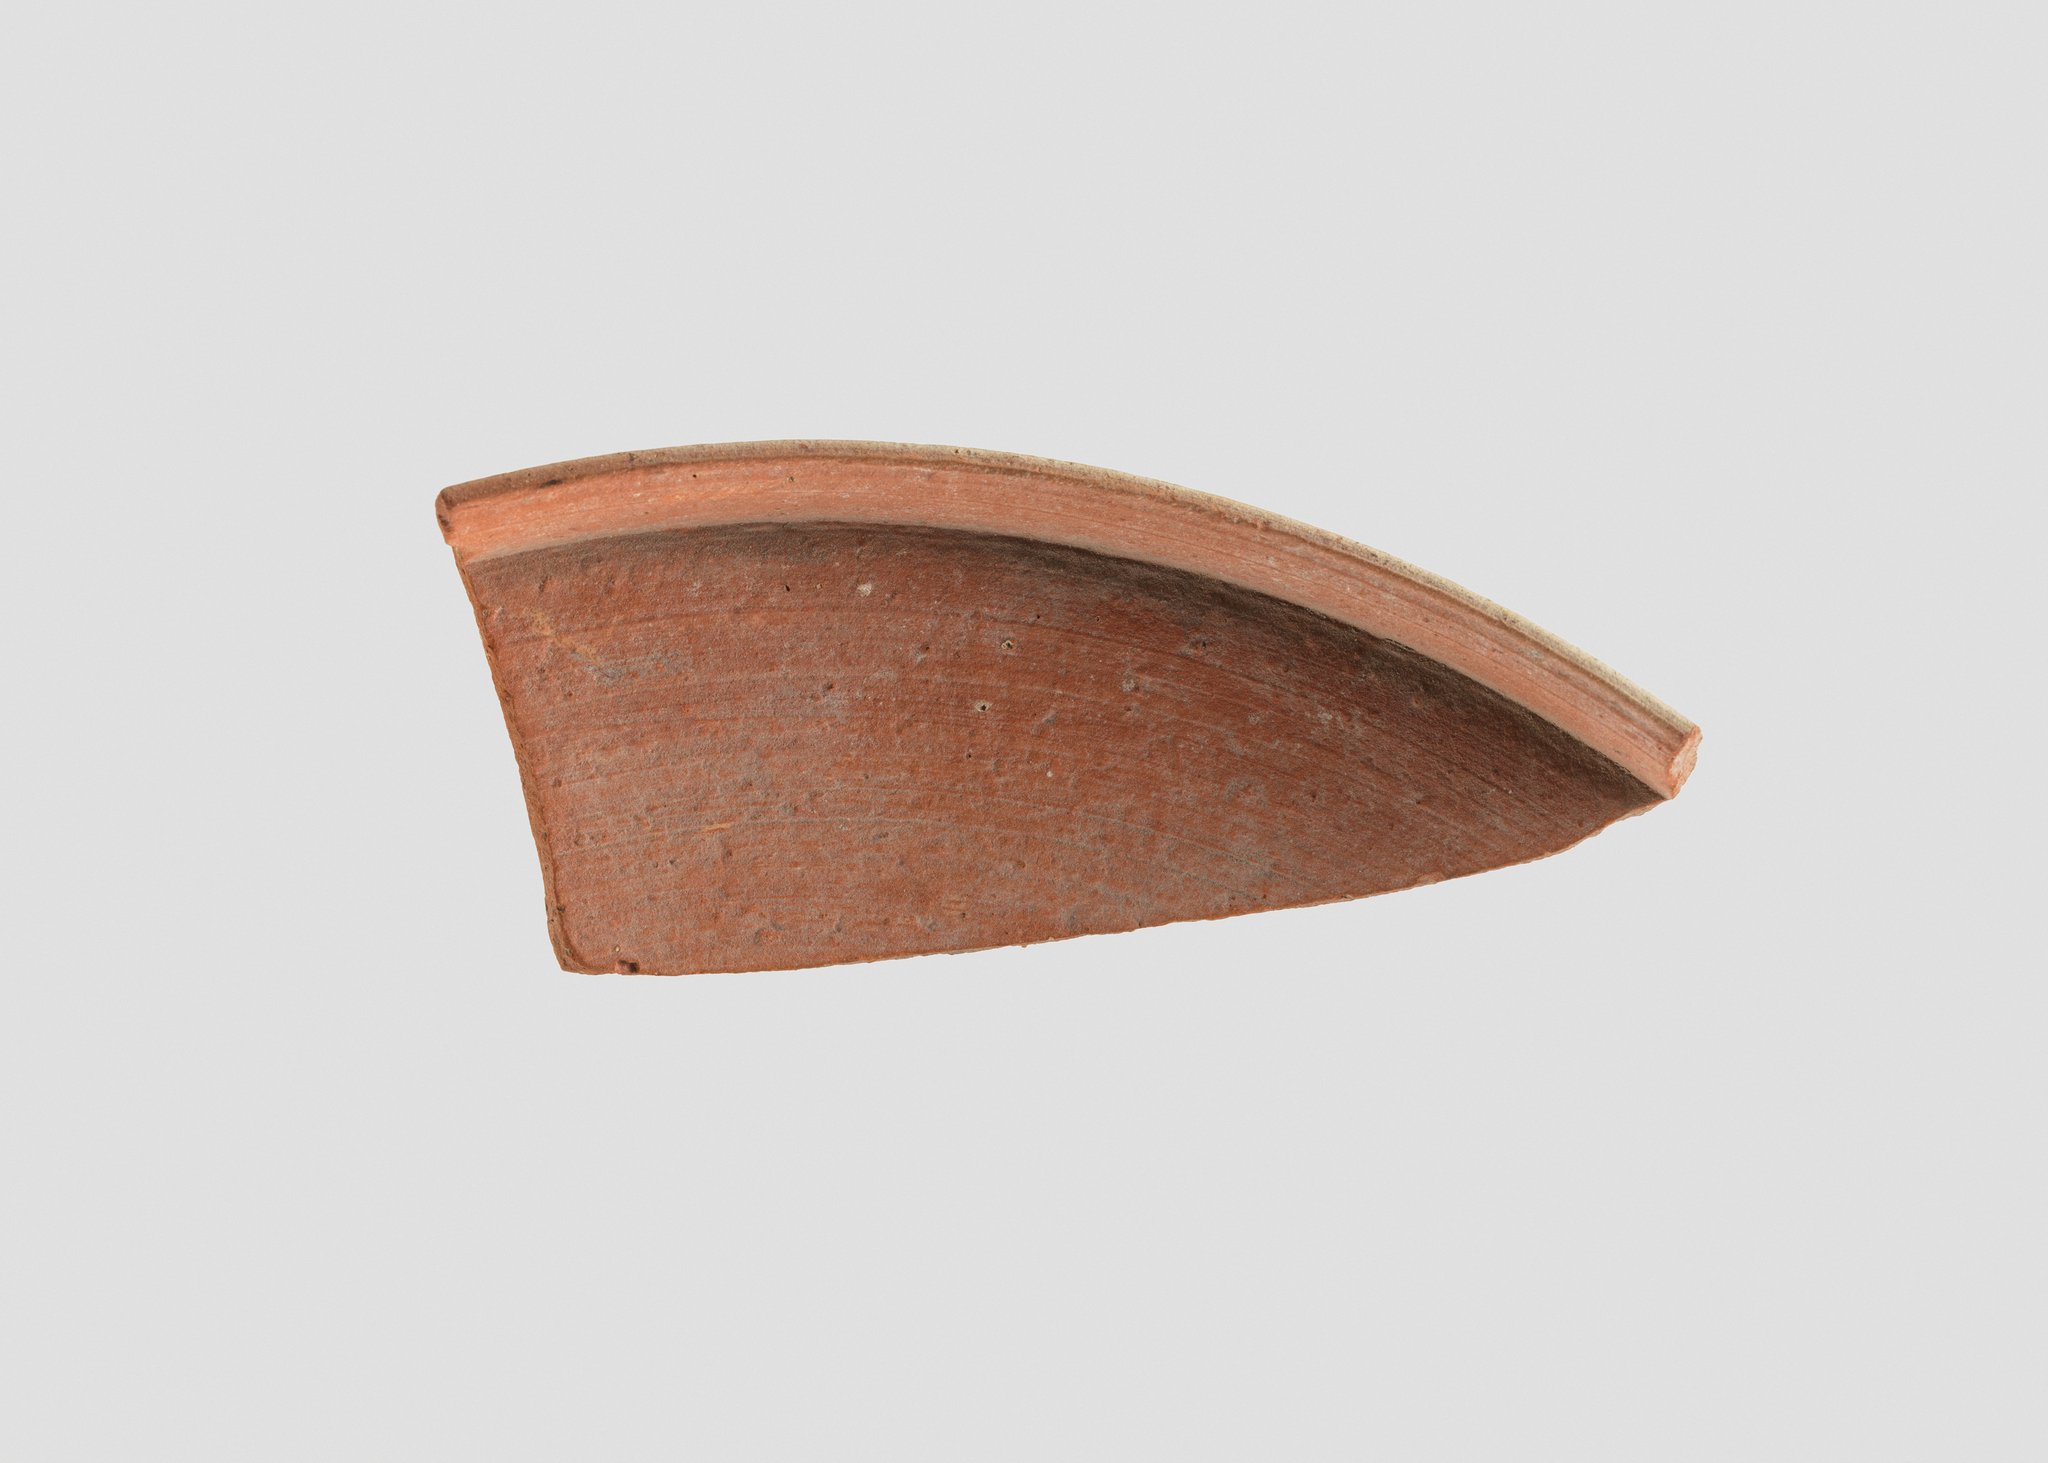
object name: sherd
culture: nabataean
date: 1-100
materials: ceramic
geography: levant